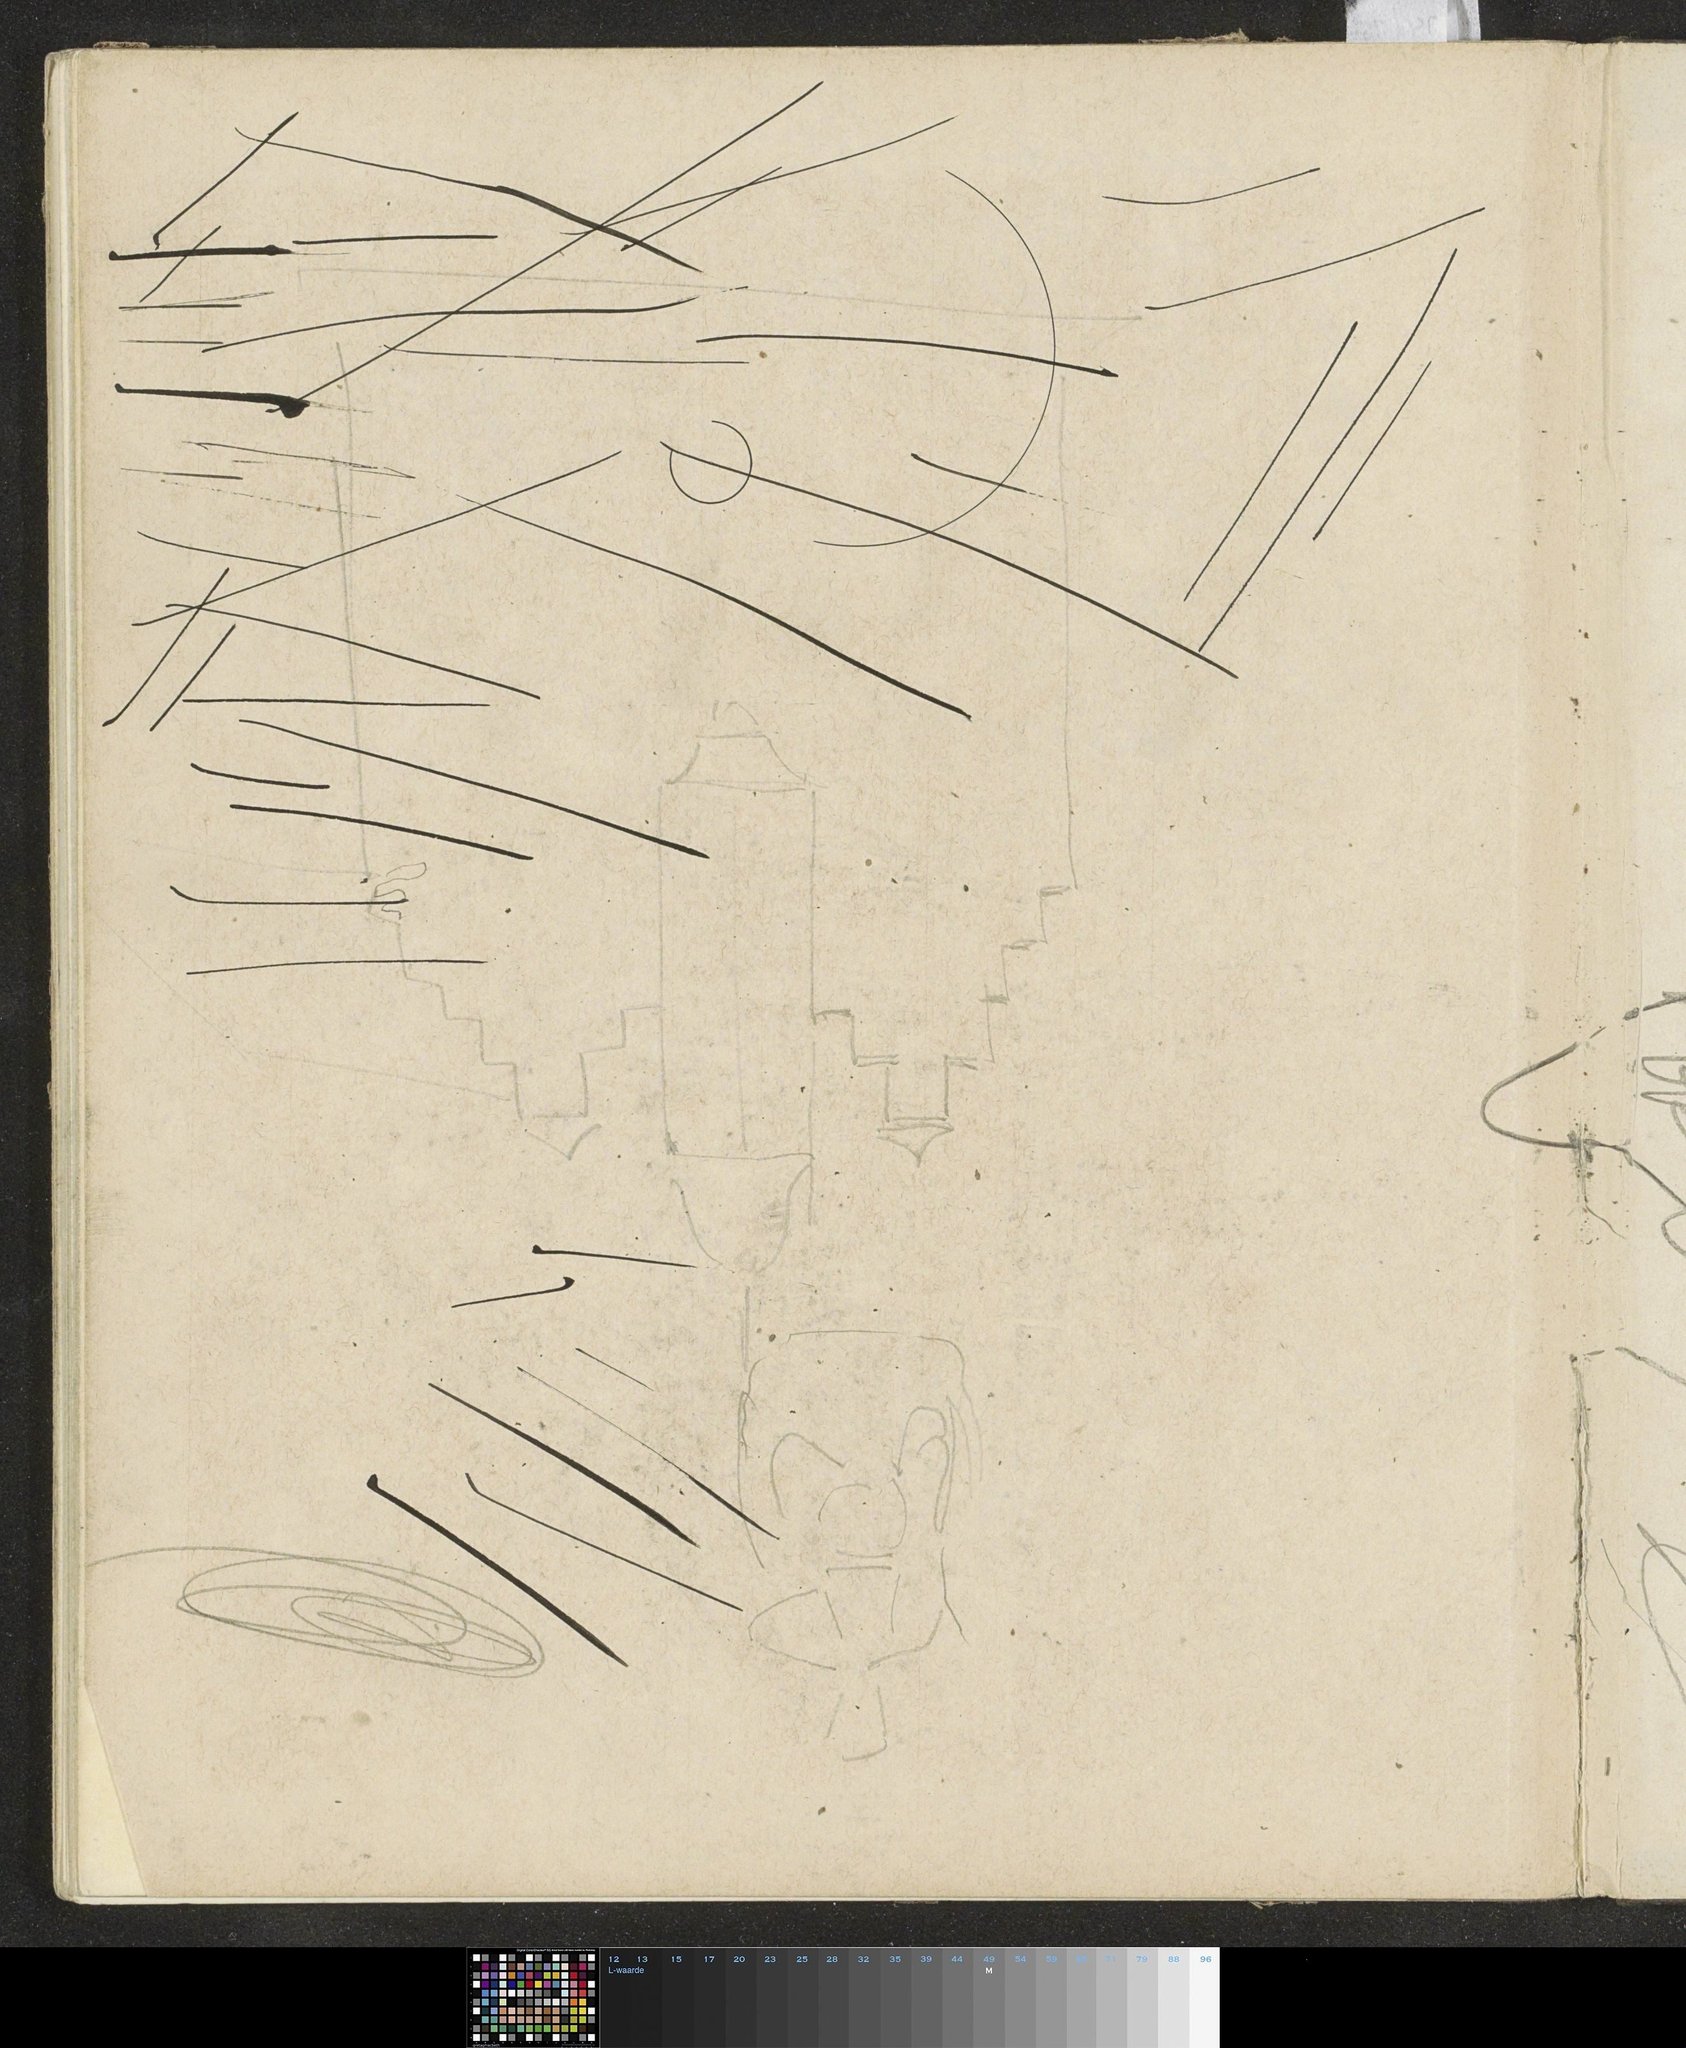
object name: sketchbook leaf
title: Architectuurstudie en een figuur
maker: carel adolph lion cachet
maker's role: draughtsman, print maker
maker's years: 1864-1945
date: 1900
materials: ink, paper, pencil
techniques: pen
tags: anatomy (non-medical), architecture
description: Blad 15 verso uit een schetsboek met 15 bladen.